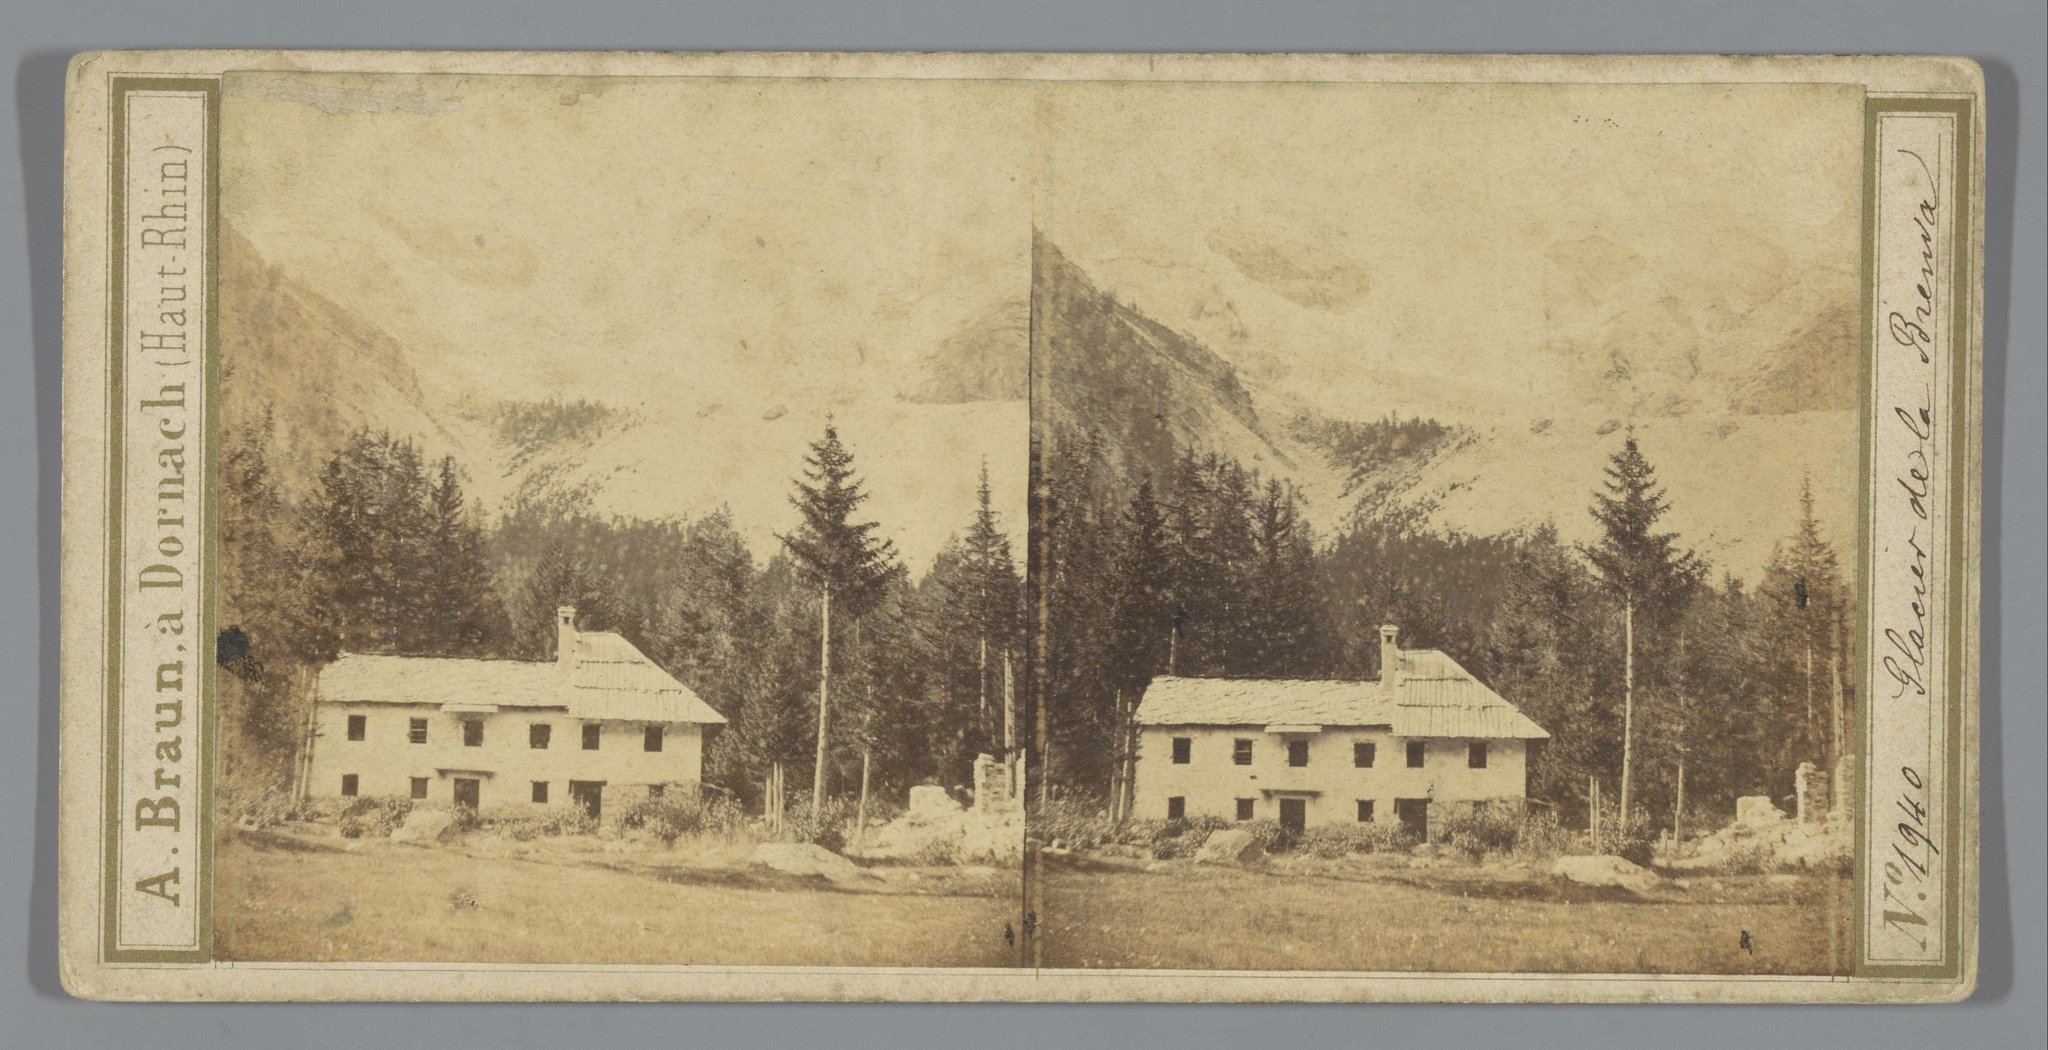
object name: stereograph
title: Glacier de la Brenva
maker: Anonymous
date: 1860-1866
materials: cardboard, paper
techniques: albumen print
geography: dornach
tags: glacier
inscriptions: number: ‘No. 1940’